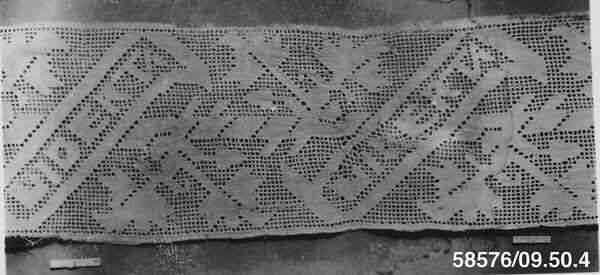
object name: strip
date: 1501-1700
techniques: embroidery